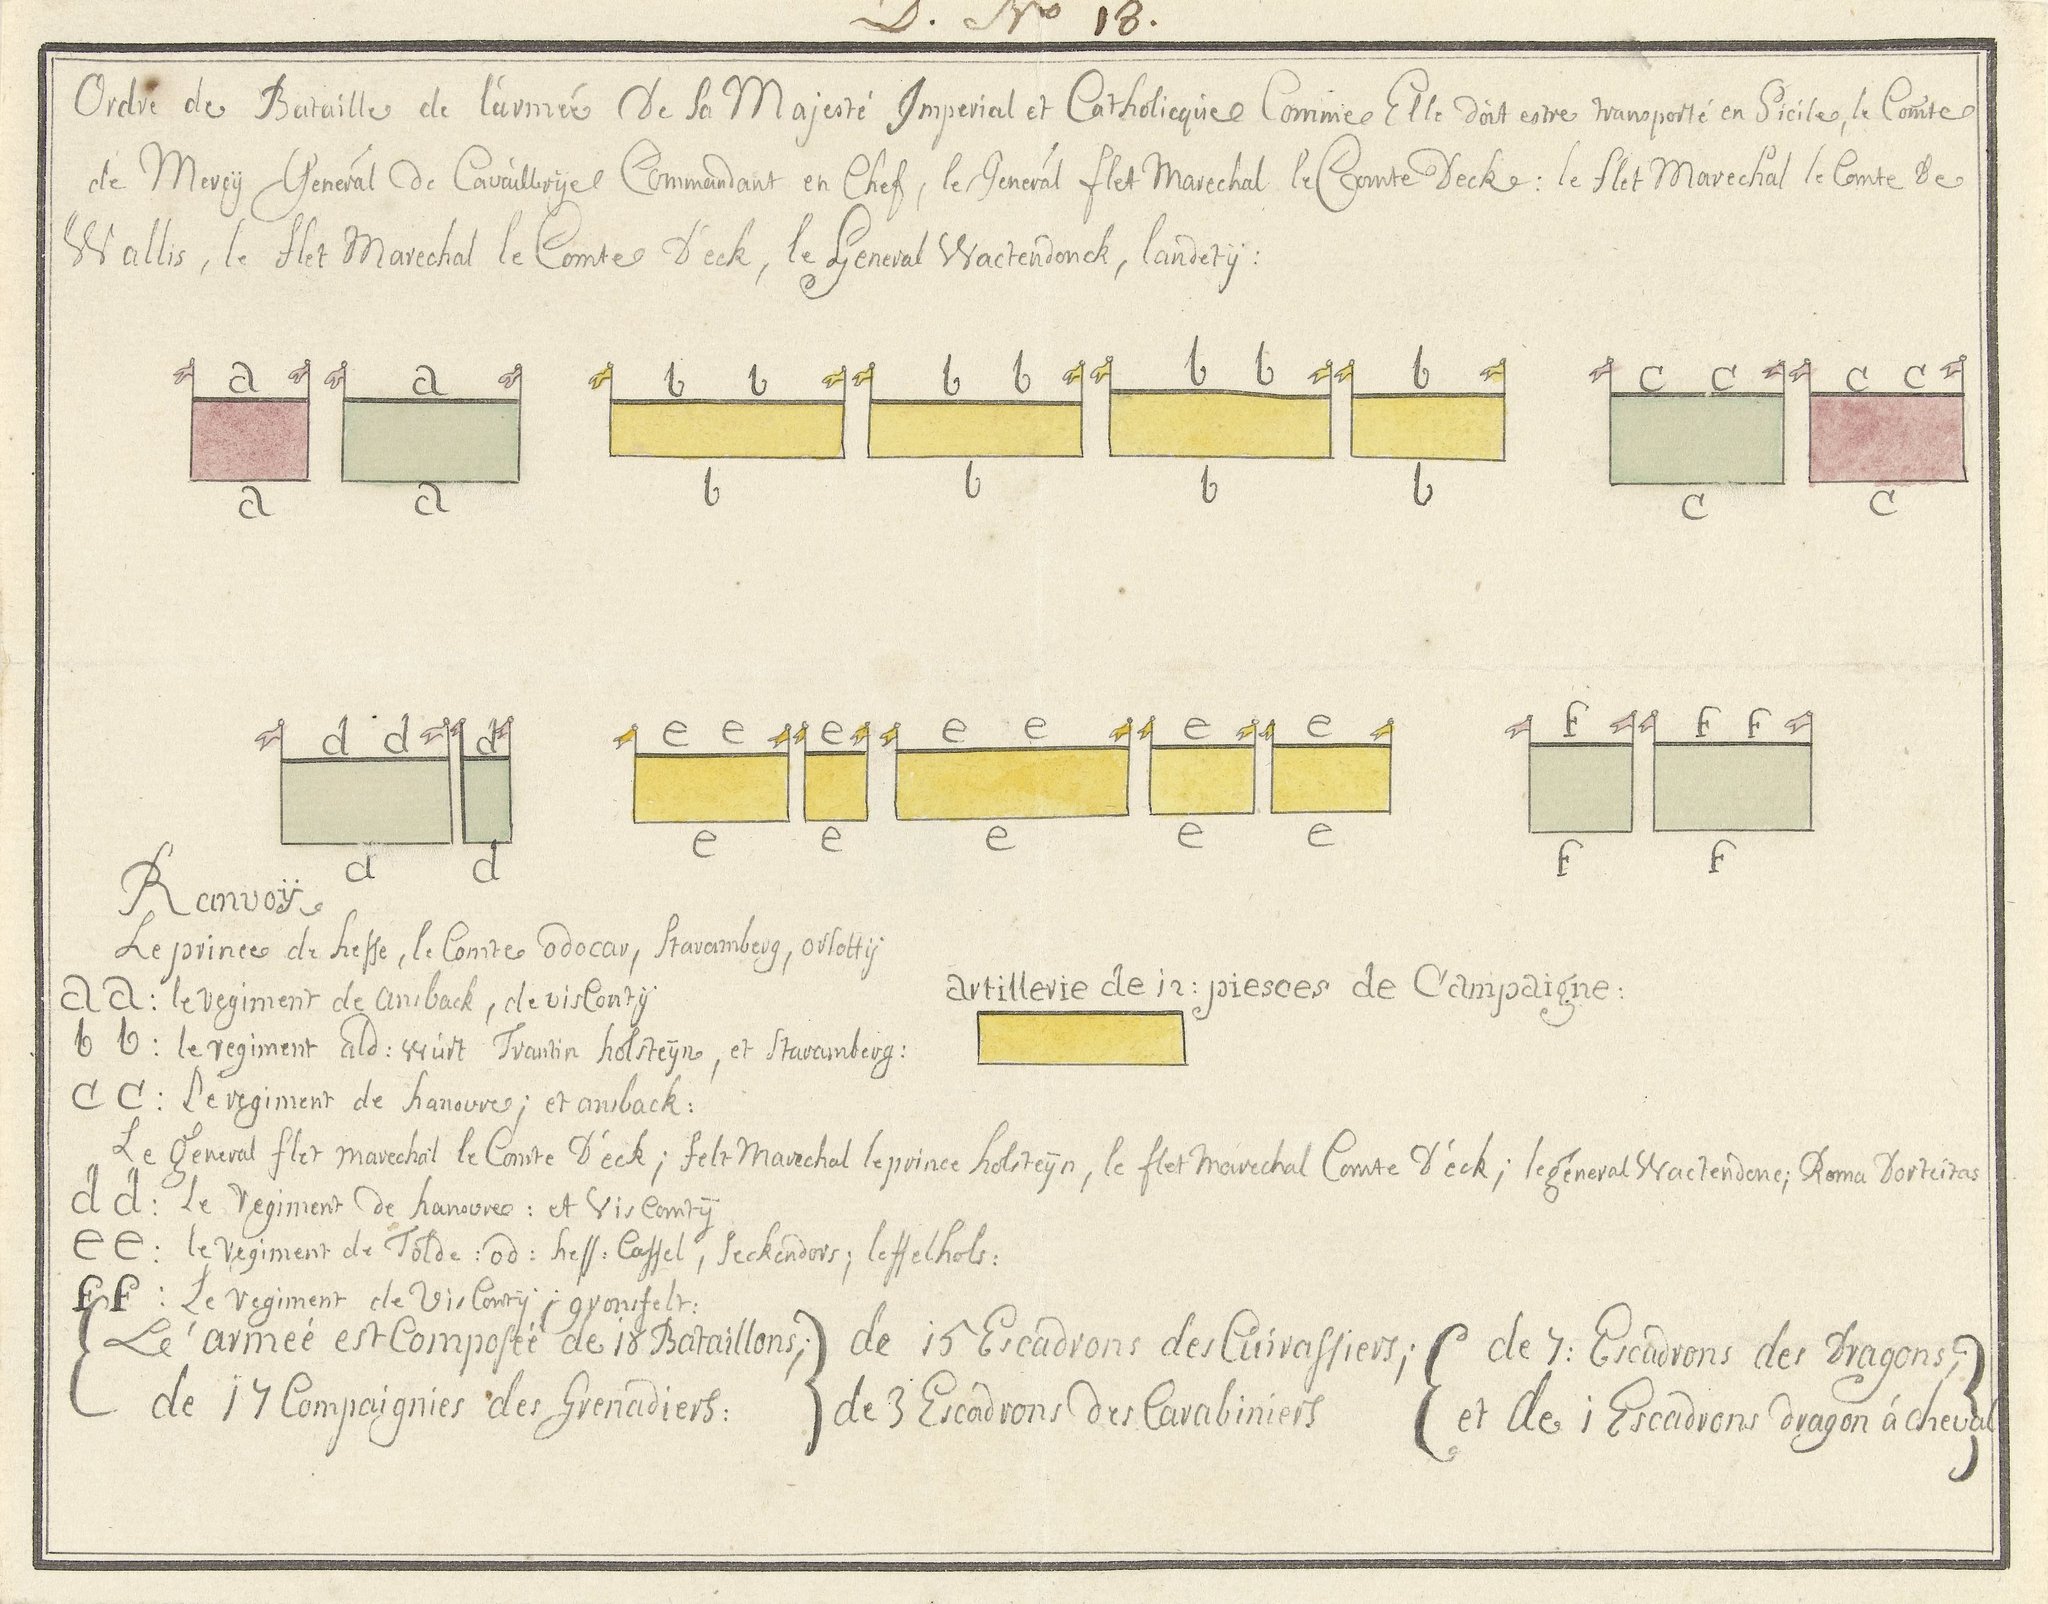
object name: drawing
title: Ordre de Batailles de l'armée de Sa Majesté Imperial et Catholique (...) en Sicile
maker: samuel du ry de champdoré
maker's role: draughtsman, engineer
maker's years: 1651-1729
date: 1701-1715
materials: paper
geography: netherlands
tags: battle arrays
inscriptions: collector's mark: Lugt 2166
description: Slagorde van het keizerlijk leger in Sicilië, ca. 1701-1715. Blad ligt los in het album. Onderdeel van een verzameling getekende plannen van versterkte plaatsen in Nederland en omringende landen ten tijde van de Spaanse Successieoorlog (deel D).